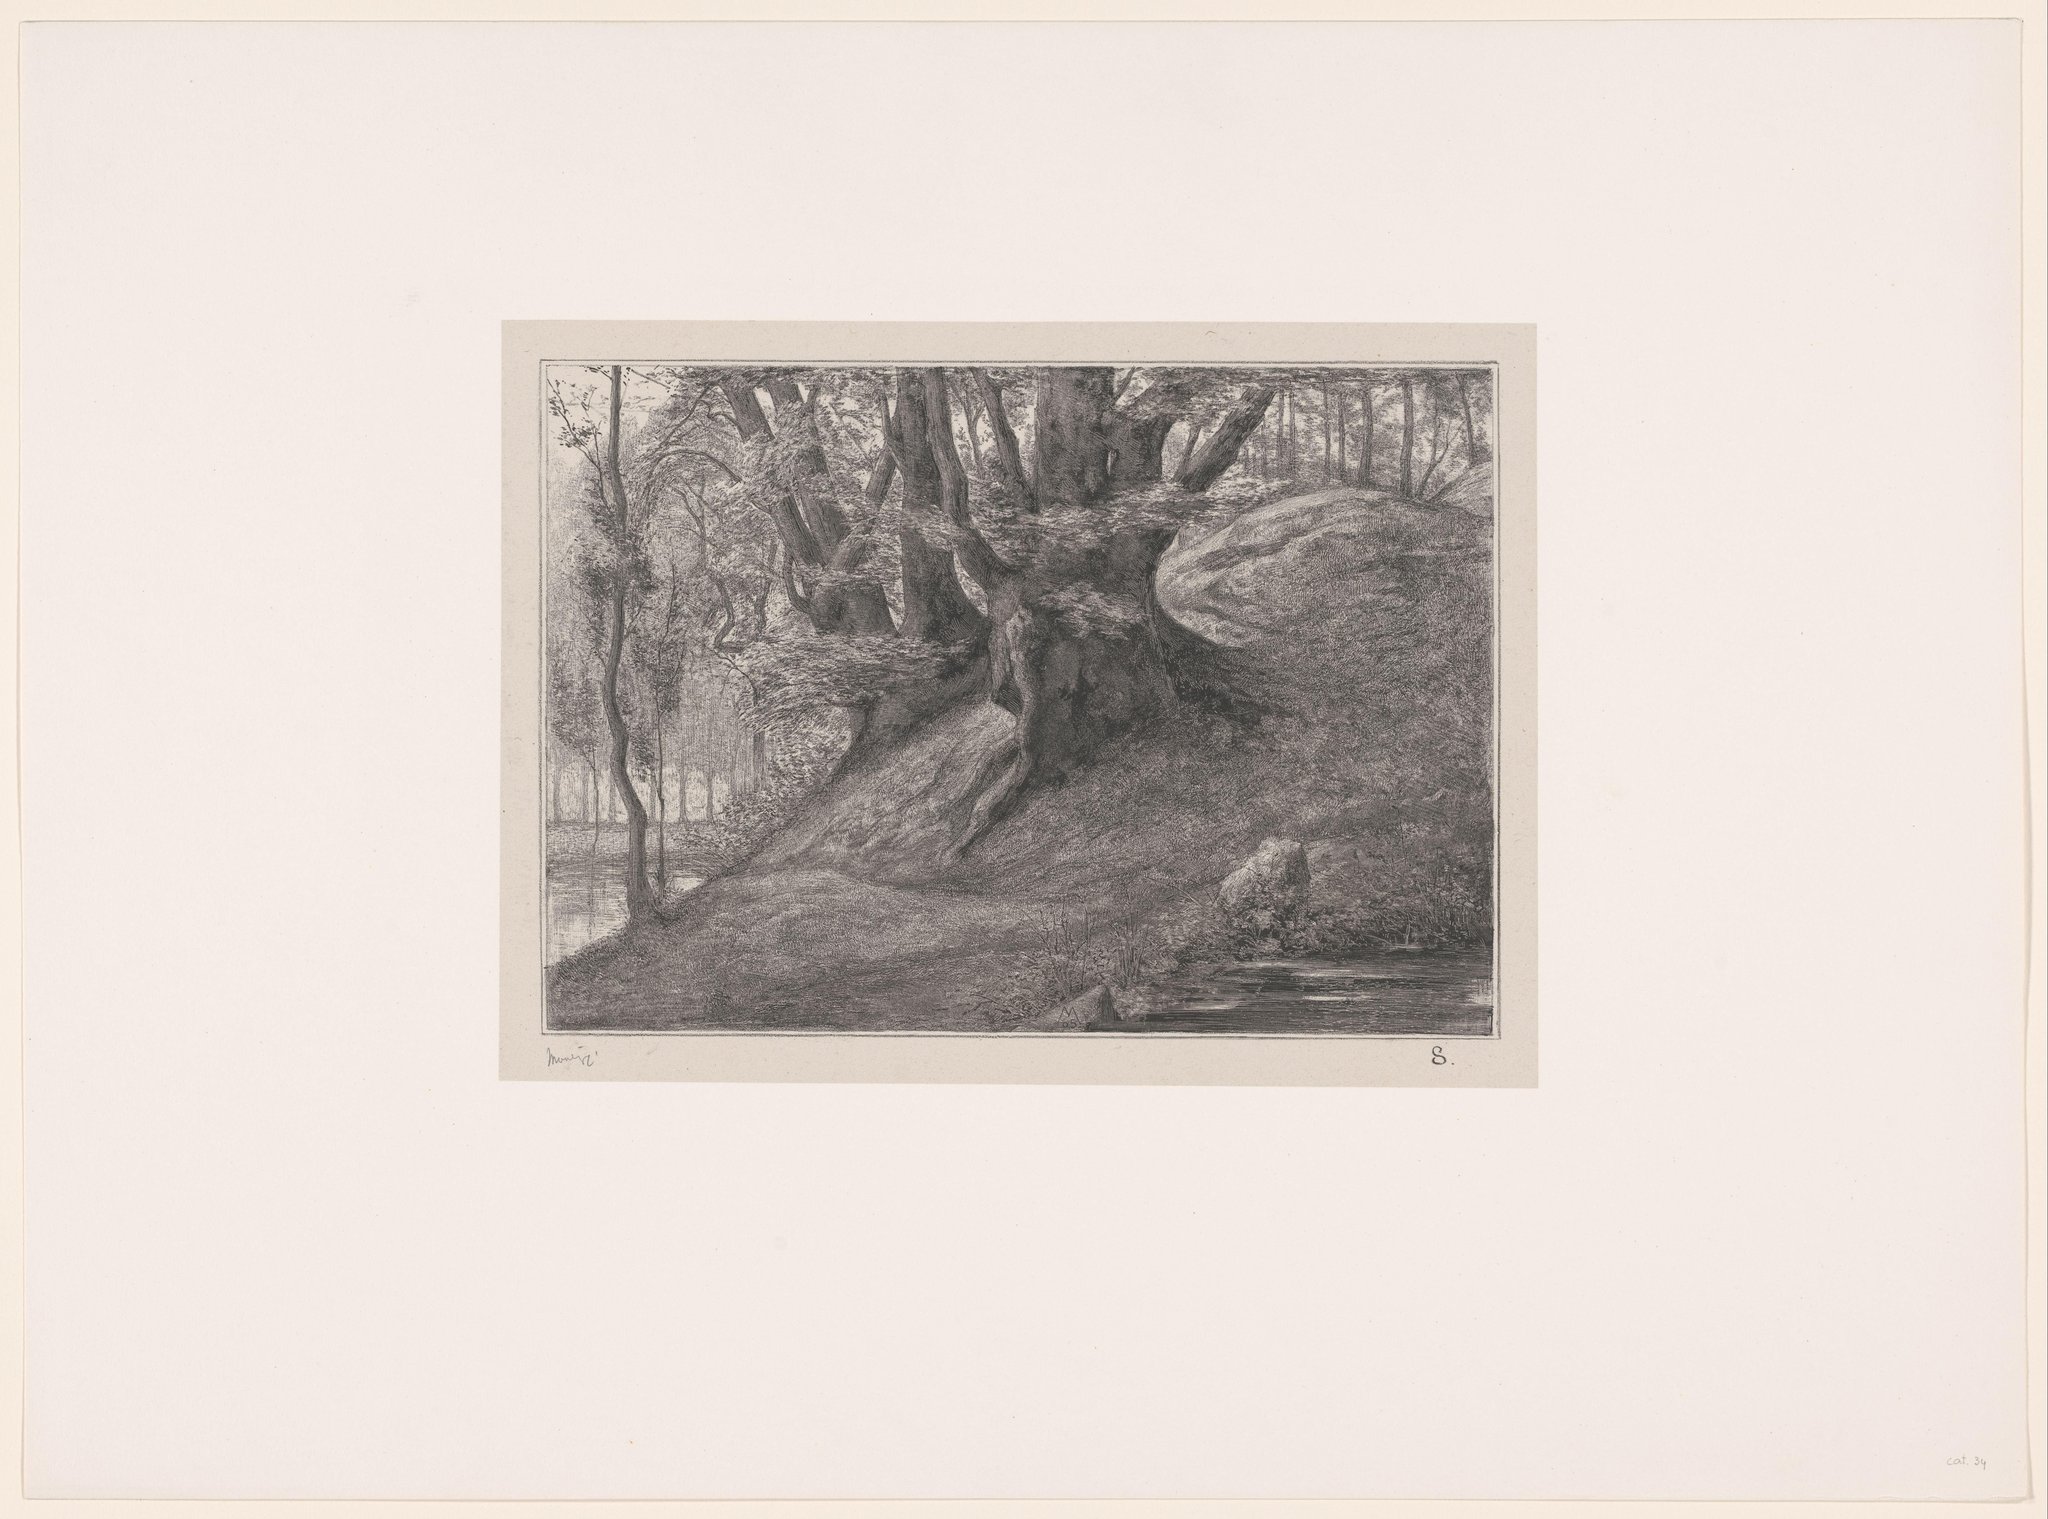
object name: print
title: De Duno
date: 1905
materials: paper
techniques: lithograph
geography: doorwerth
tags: trees, pond, pool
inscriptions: collector's mark: Lugt 2228